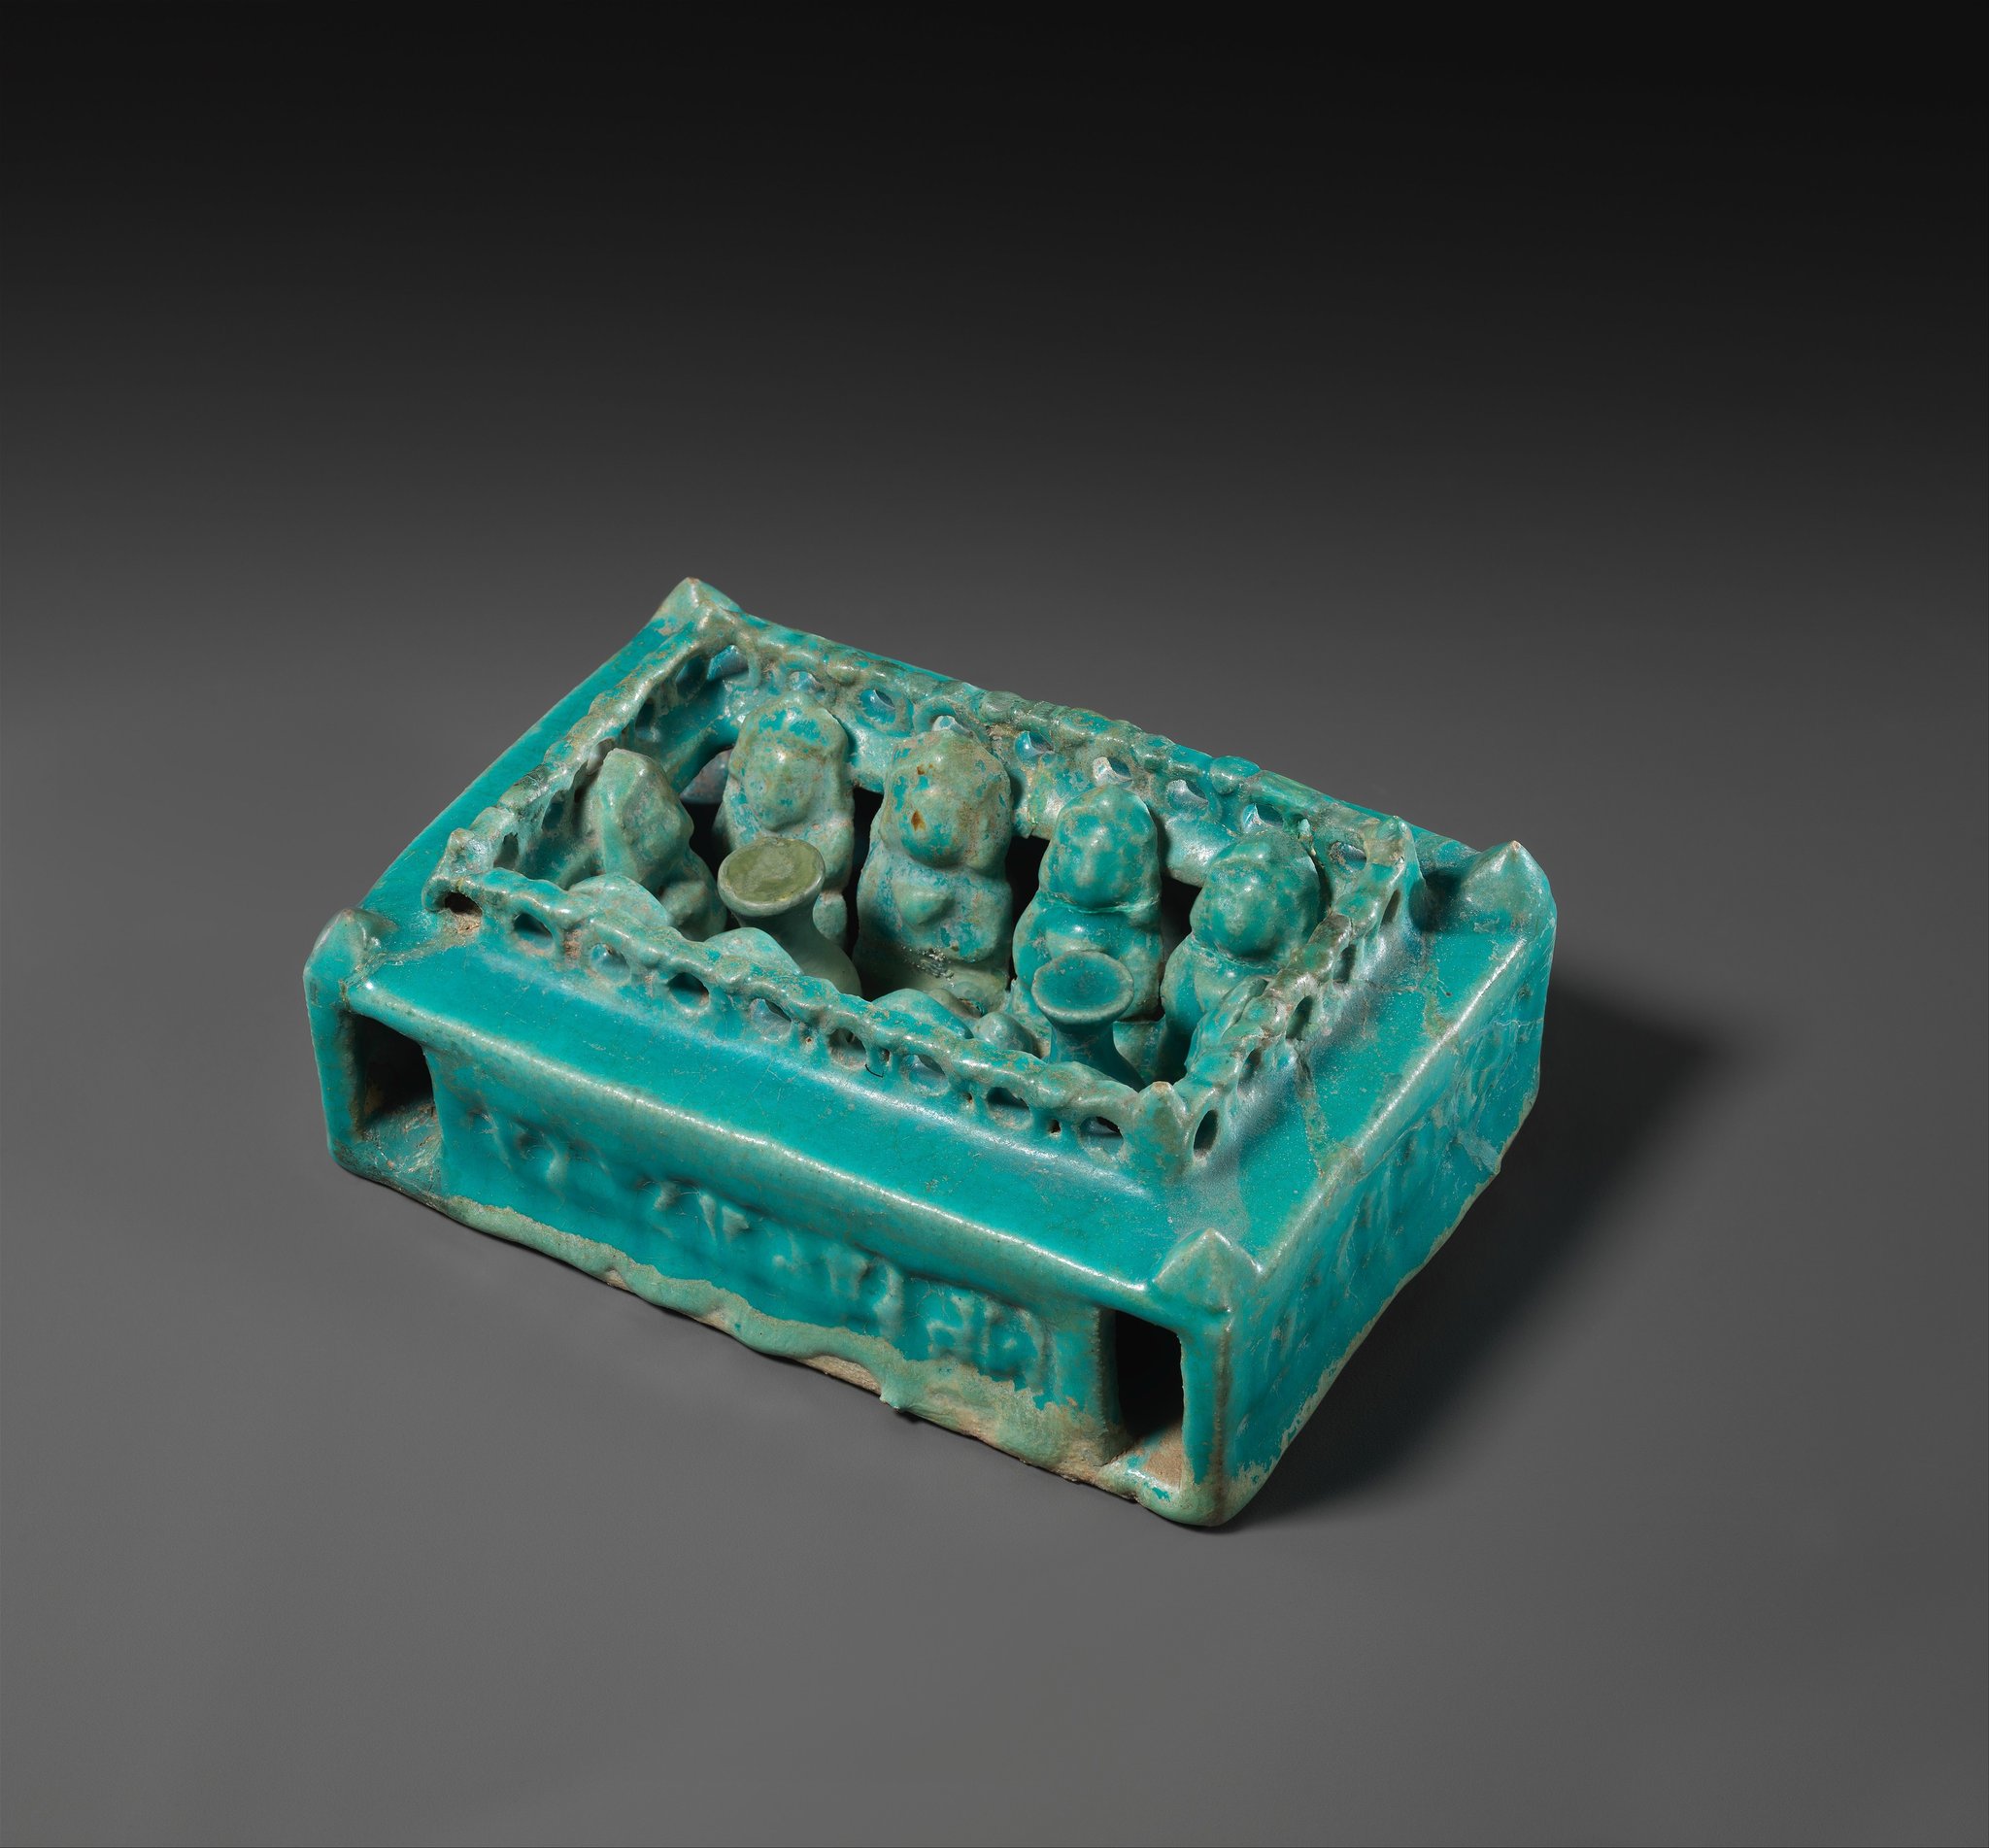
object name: model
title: Model of a House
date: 1101-1300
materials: stonepaste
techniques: molding, relief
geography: iran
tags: houses